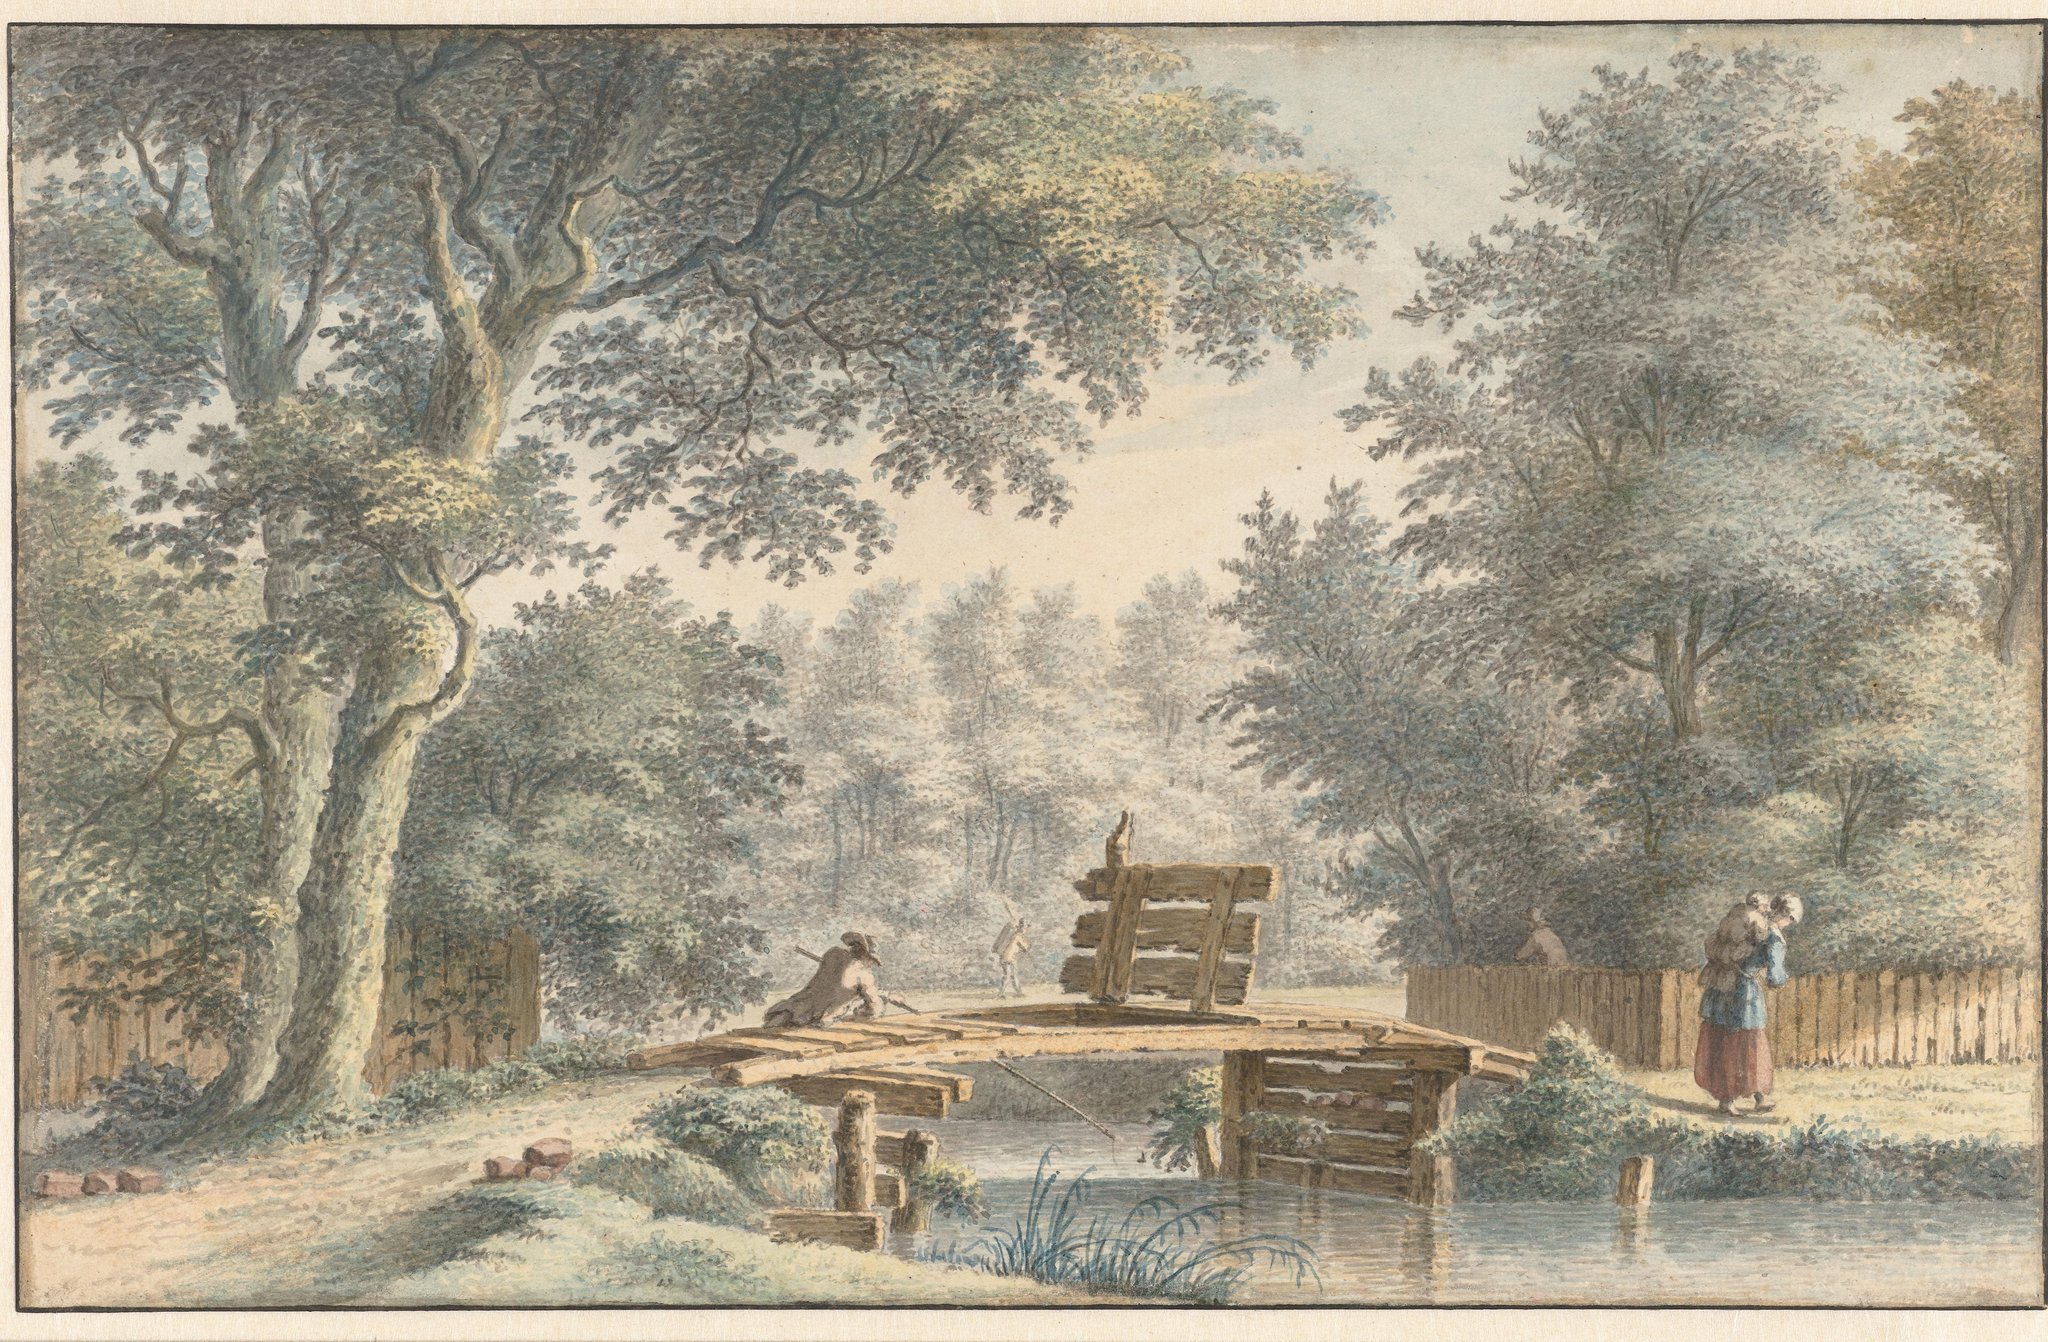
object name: watercolor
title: Landschap met een brug waarop een hengelaar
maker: gerard van rossum (1698/99-1772)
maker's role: draughtsman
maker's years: 1698-1772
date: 1763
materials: chalk, paper, watercolor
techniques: brush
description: Landschap met een brug waarop een hengelaar, rechts een vrouw met een kind op de rug.